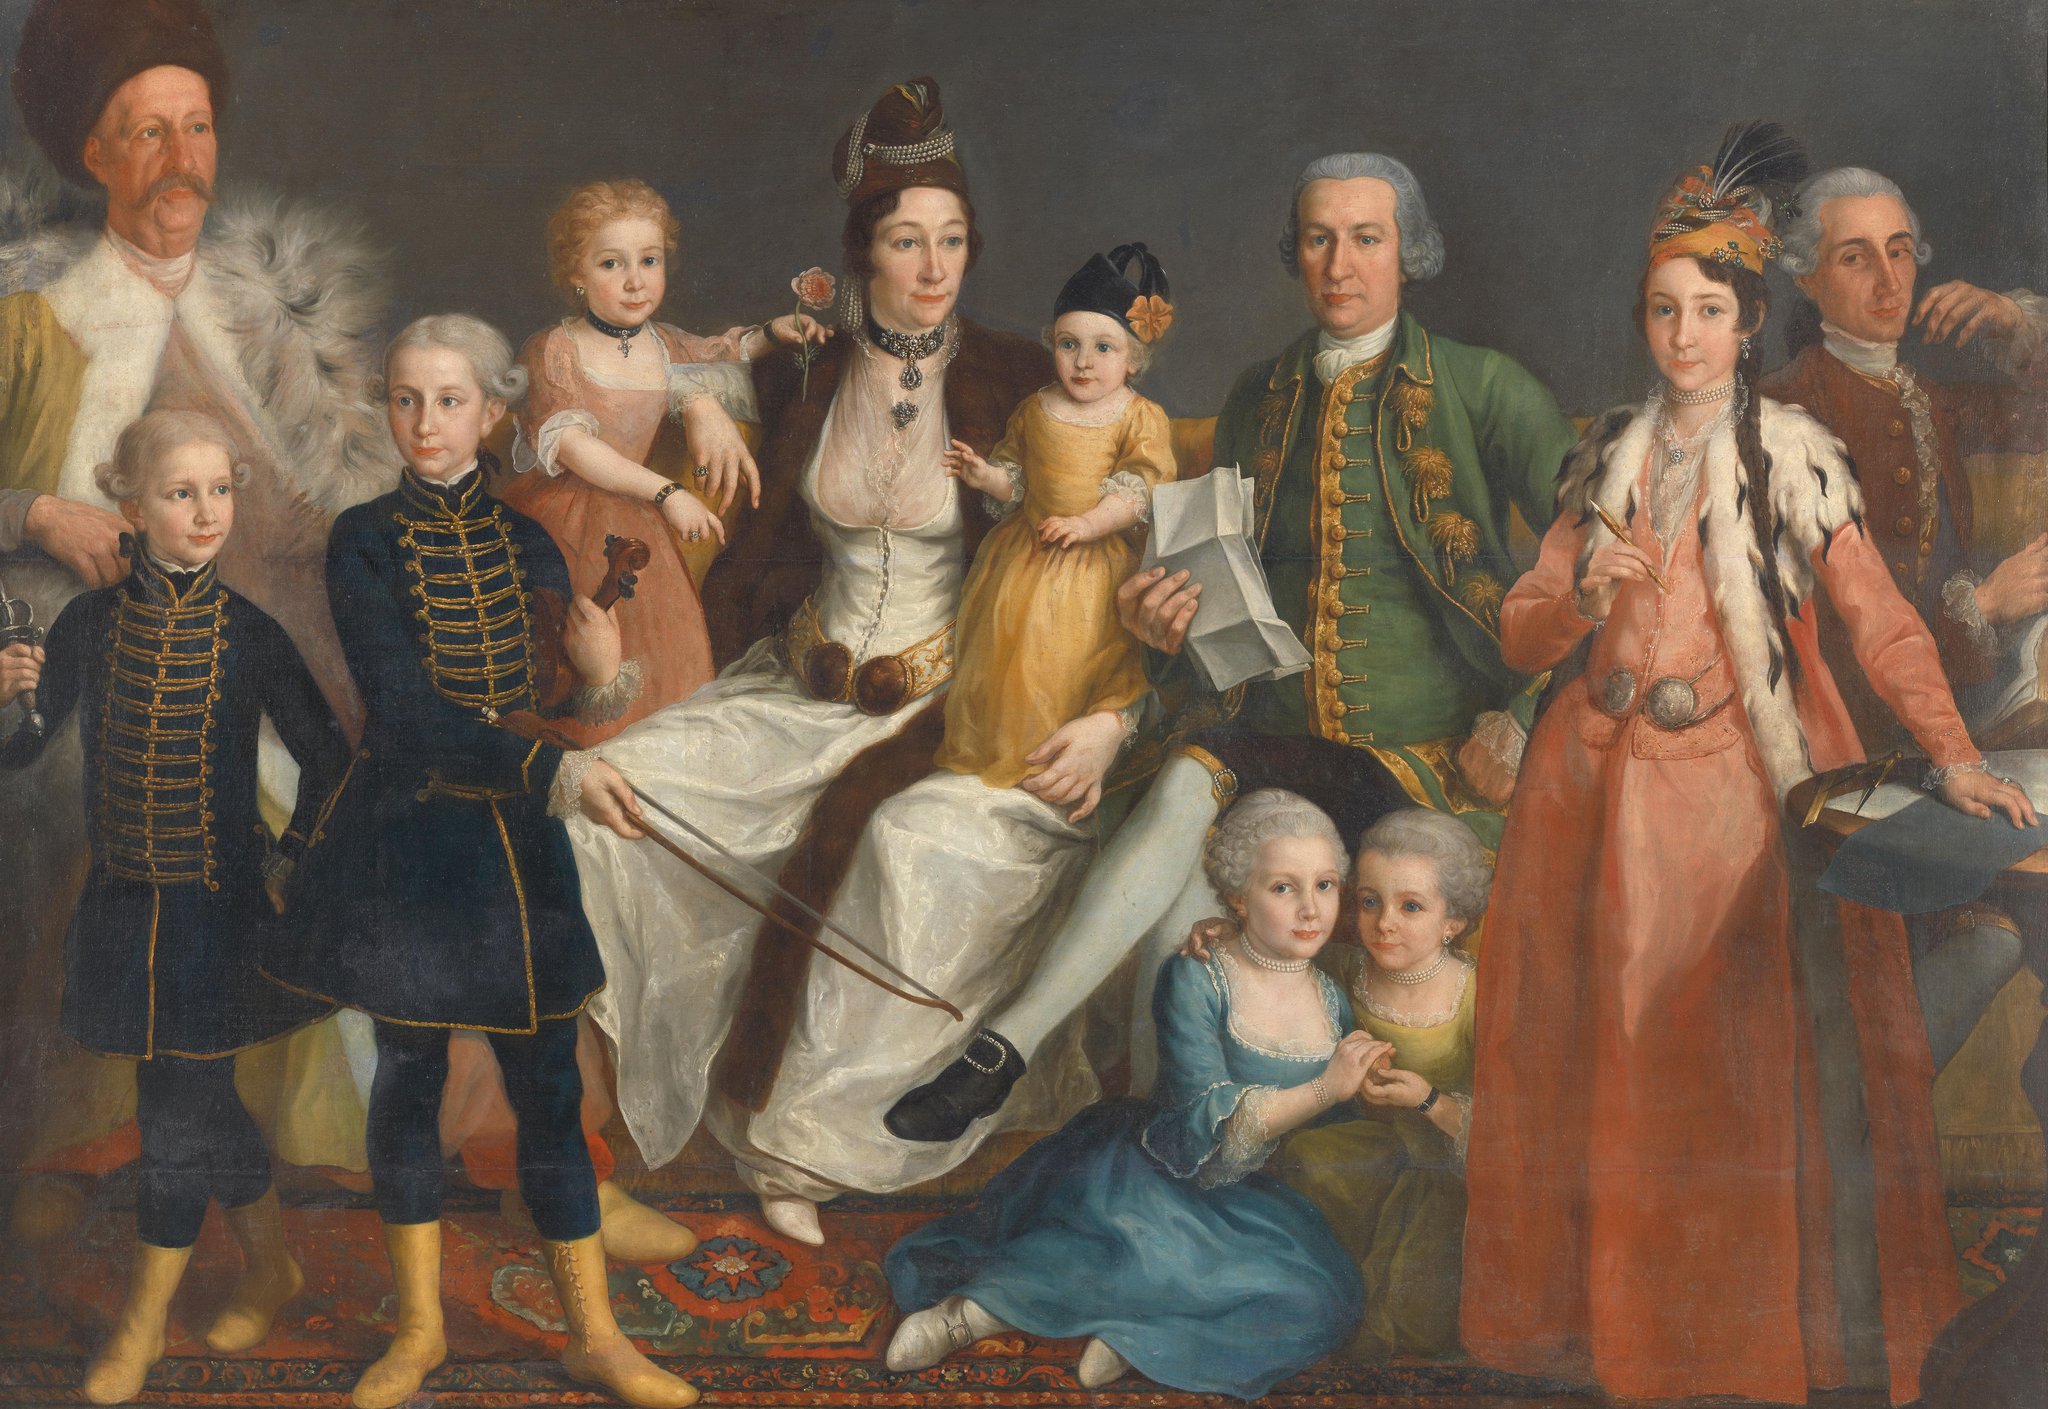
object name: painting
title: Portrait of the Van Lennep Family, a Merchant Family in Izmir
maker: antoine de favray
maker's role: painter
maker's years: 1706-1792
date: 1769-1771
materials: canvas, oil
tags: david george van lennep, smyrna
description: In the centre of this painting we see David George van Lennep and his wife Anna Maria Leidstar seated on a yellow divan. They belonged to the Levantine elite of the city of Smyrna (now Izmir, in Turkey). These were mostly families originally from the Netherlands who no longer spoke Dutch and had adopted Turkish customs and dress. At the far left is Anna Maria’s father, the textile merchant Justinus Leidstar.